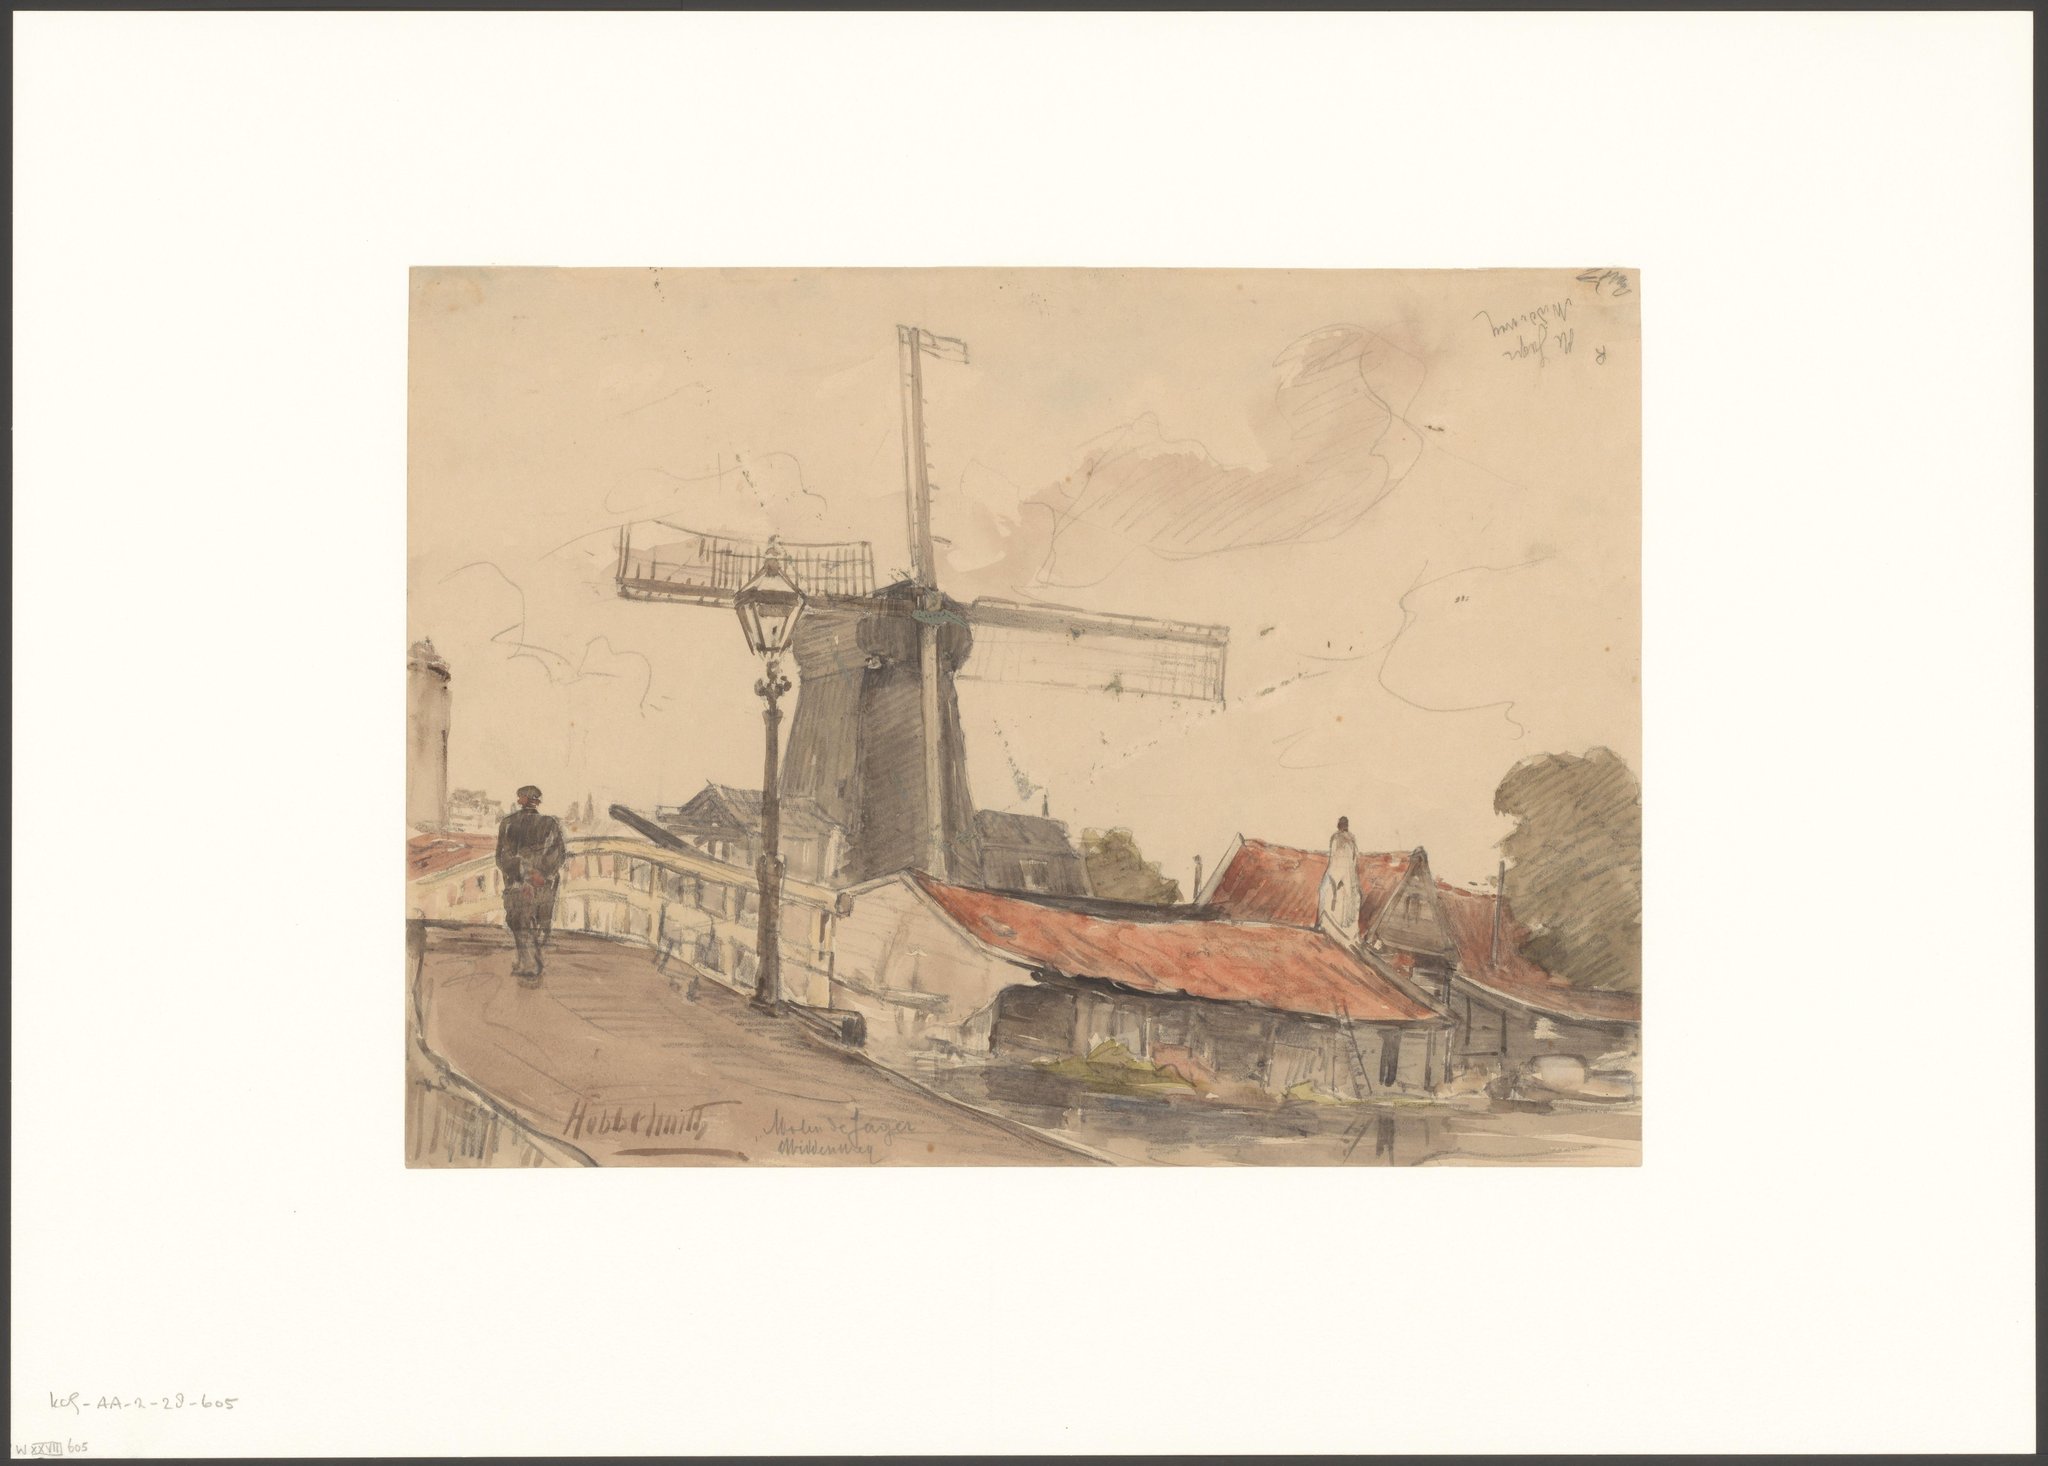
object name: drawing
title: Gezicht op molen De Jager aan de Middenweg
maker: hobbe smith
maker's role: painter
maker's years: 1862-1942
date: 1872-1907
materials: chalk, paper, watercolor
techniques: brush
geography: amsterdam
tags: city-view in general; 'veduta', road, path, windmill in landscape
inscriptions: stamp: ‘J. van Eck.’, collector's mark: Lugt 800a, signature: ‘HobbeSmith’, inscription: ‘de Jager / Middenweg / Molen de Jager / Middenweg’, inscription: ‘75-96 / schilderij (...) veiling Roos / f780’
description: Tekening binnen de Atlas Van Eck ingedeeld op wijknummer 28.